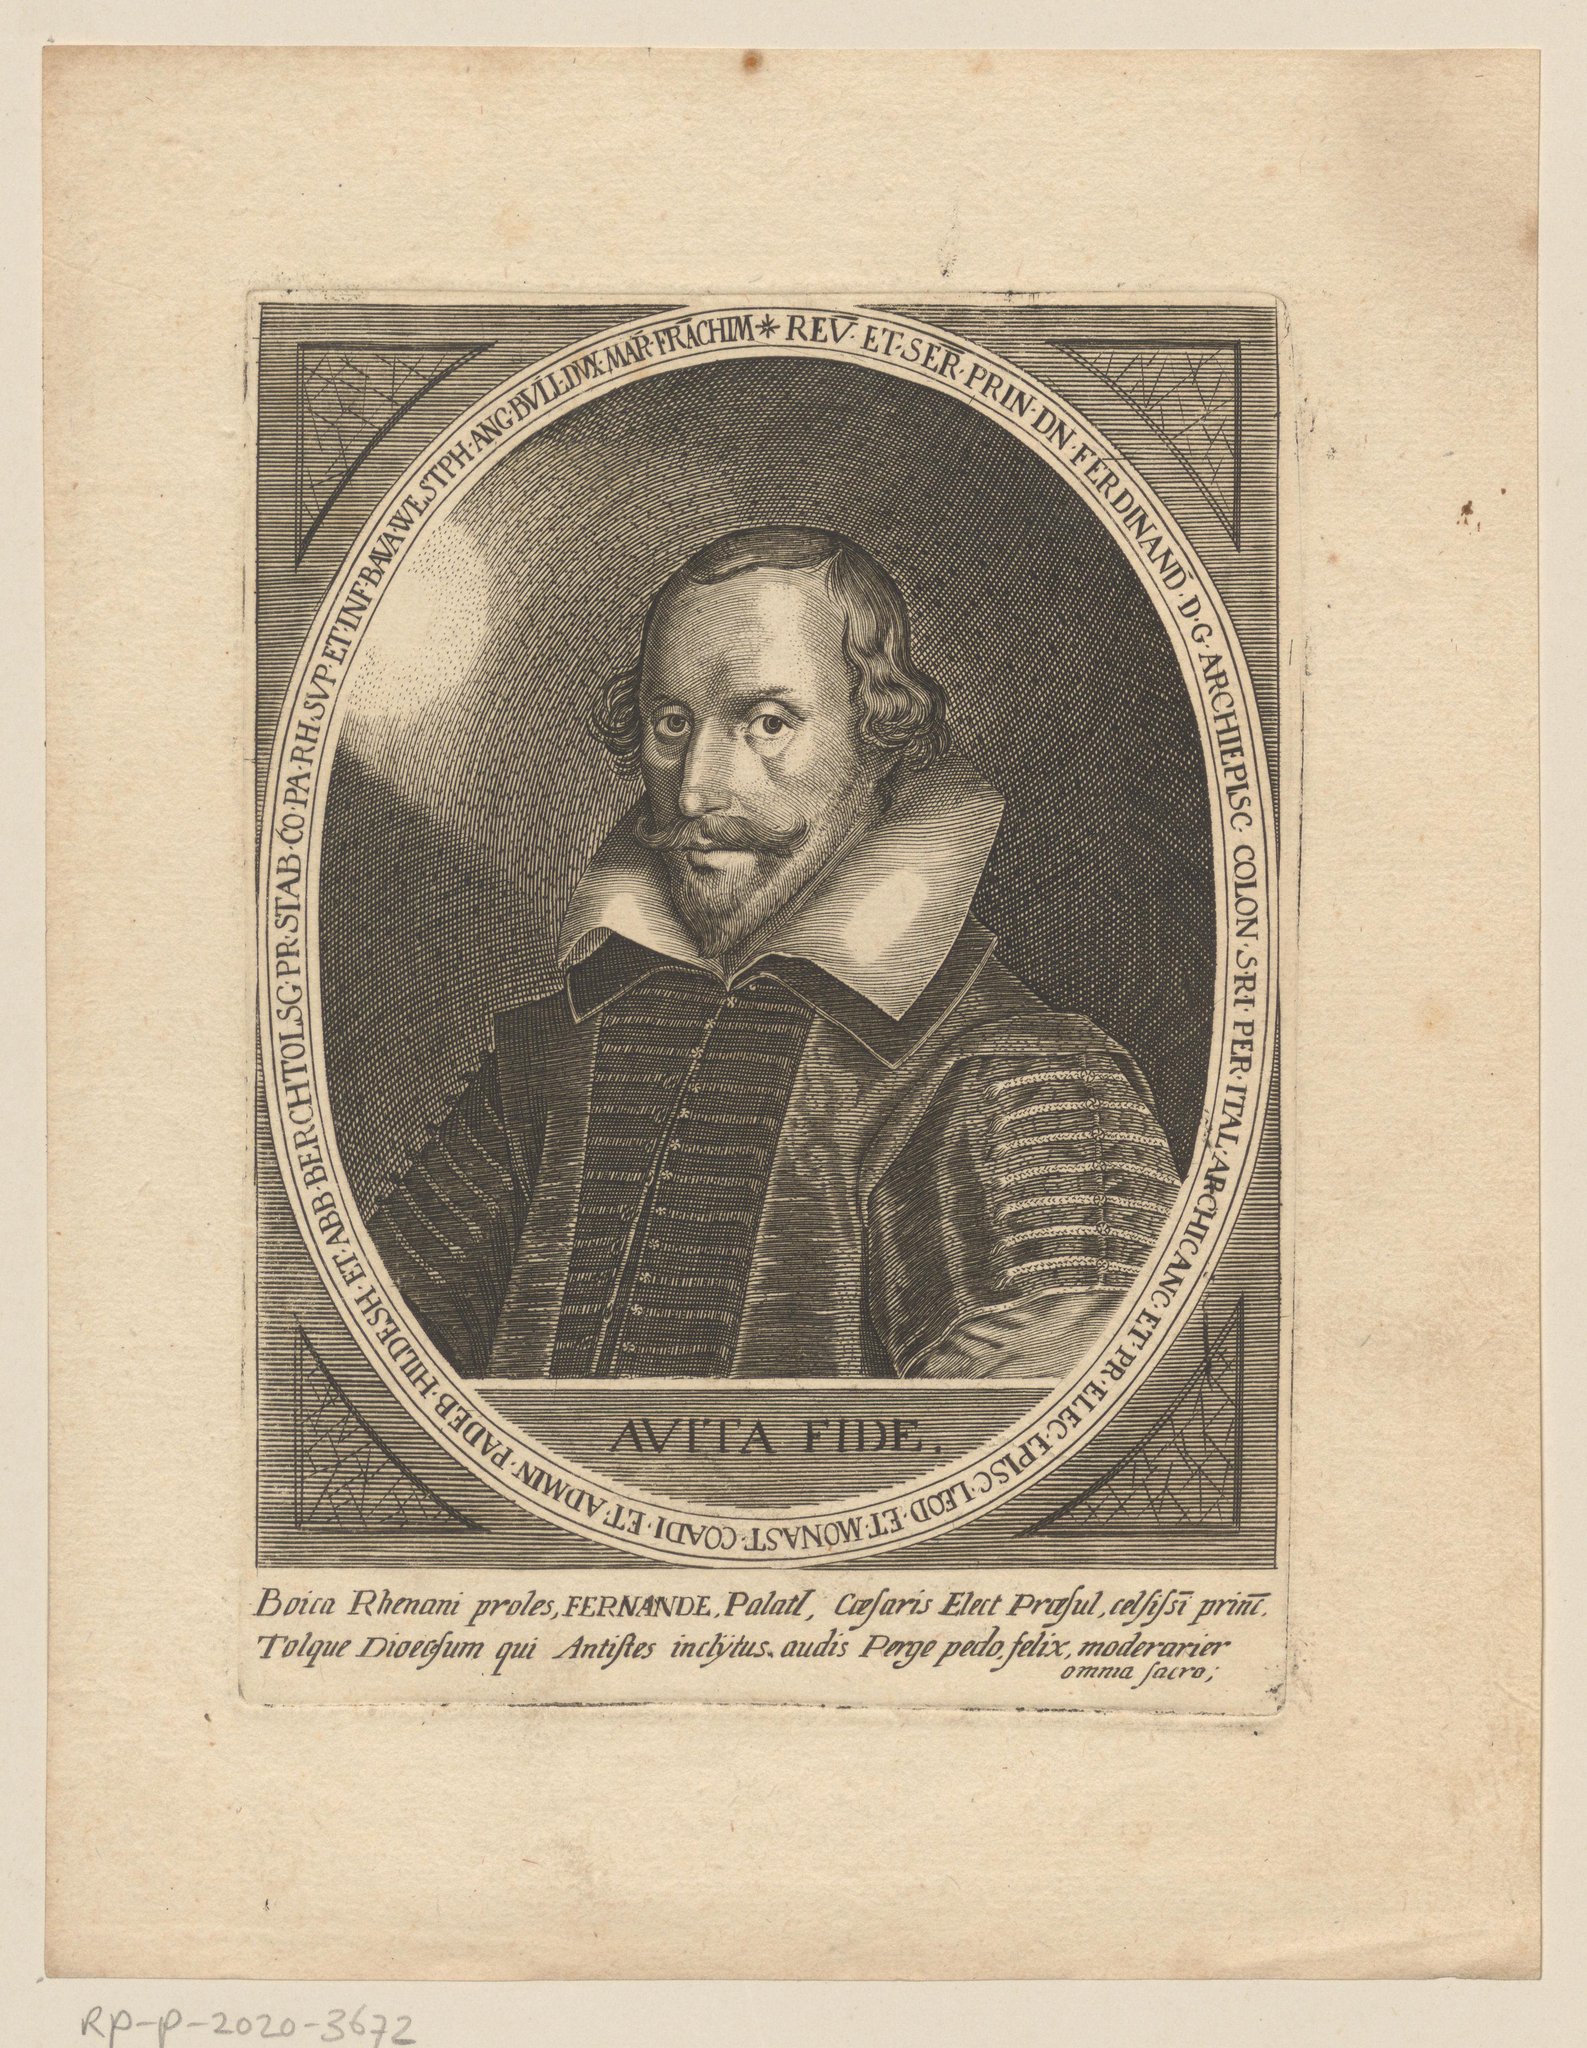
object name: print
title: Portret van Ferdinand van Beieren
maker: dominicus custos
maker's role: print maker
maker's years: 1560-1615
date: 1629-1641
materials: paper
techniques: engraving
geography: germany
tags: ferdinand van beieren, historical persons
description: Prent met tekst op verso gebruikt in publicaties uit 1629, 1632 en 1641.